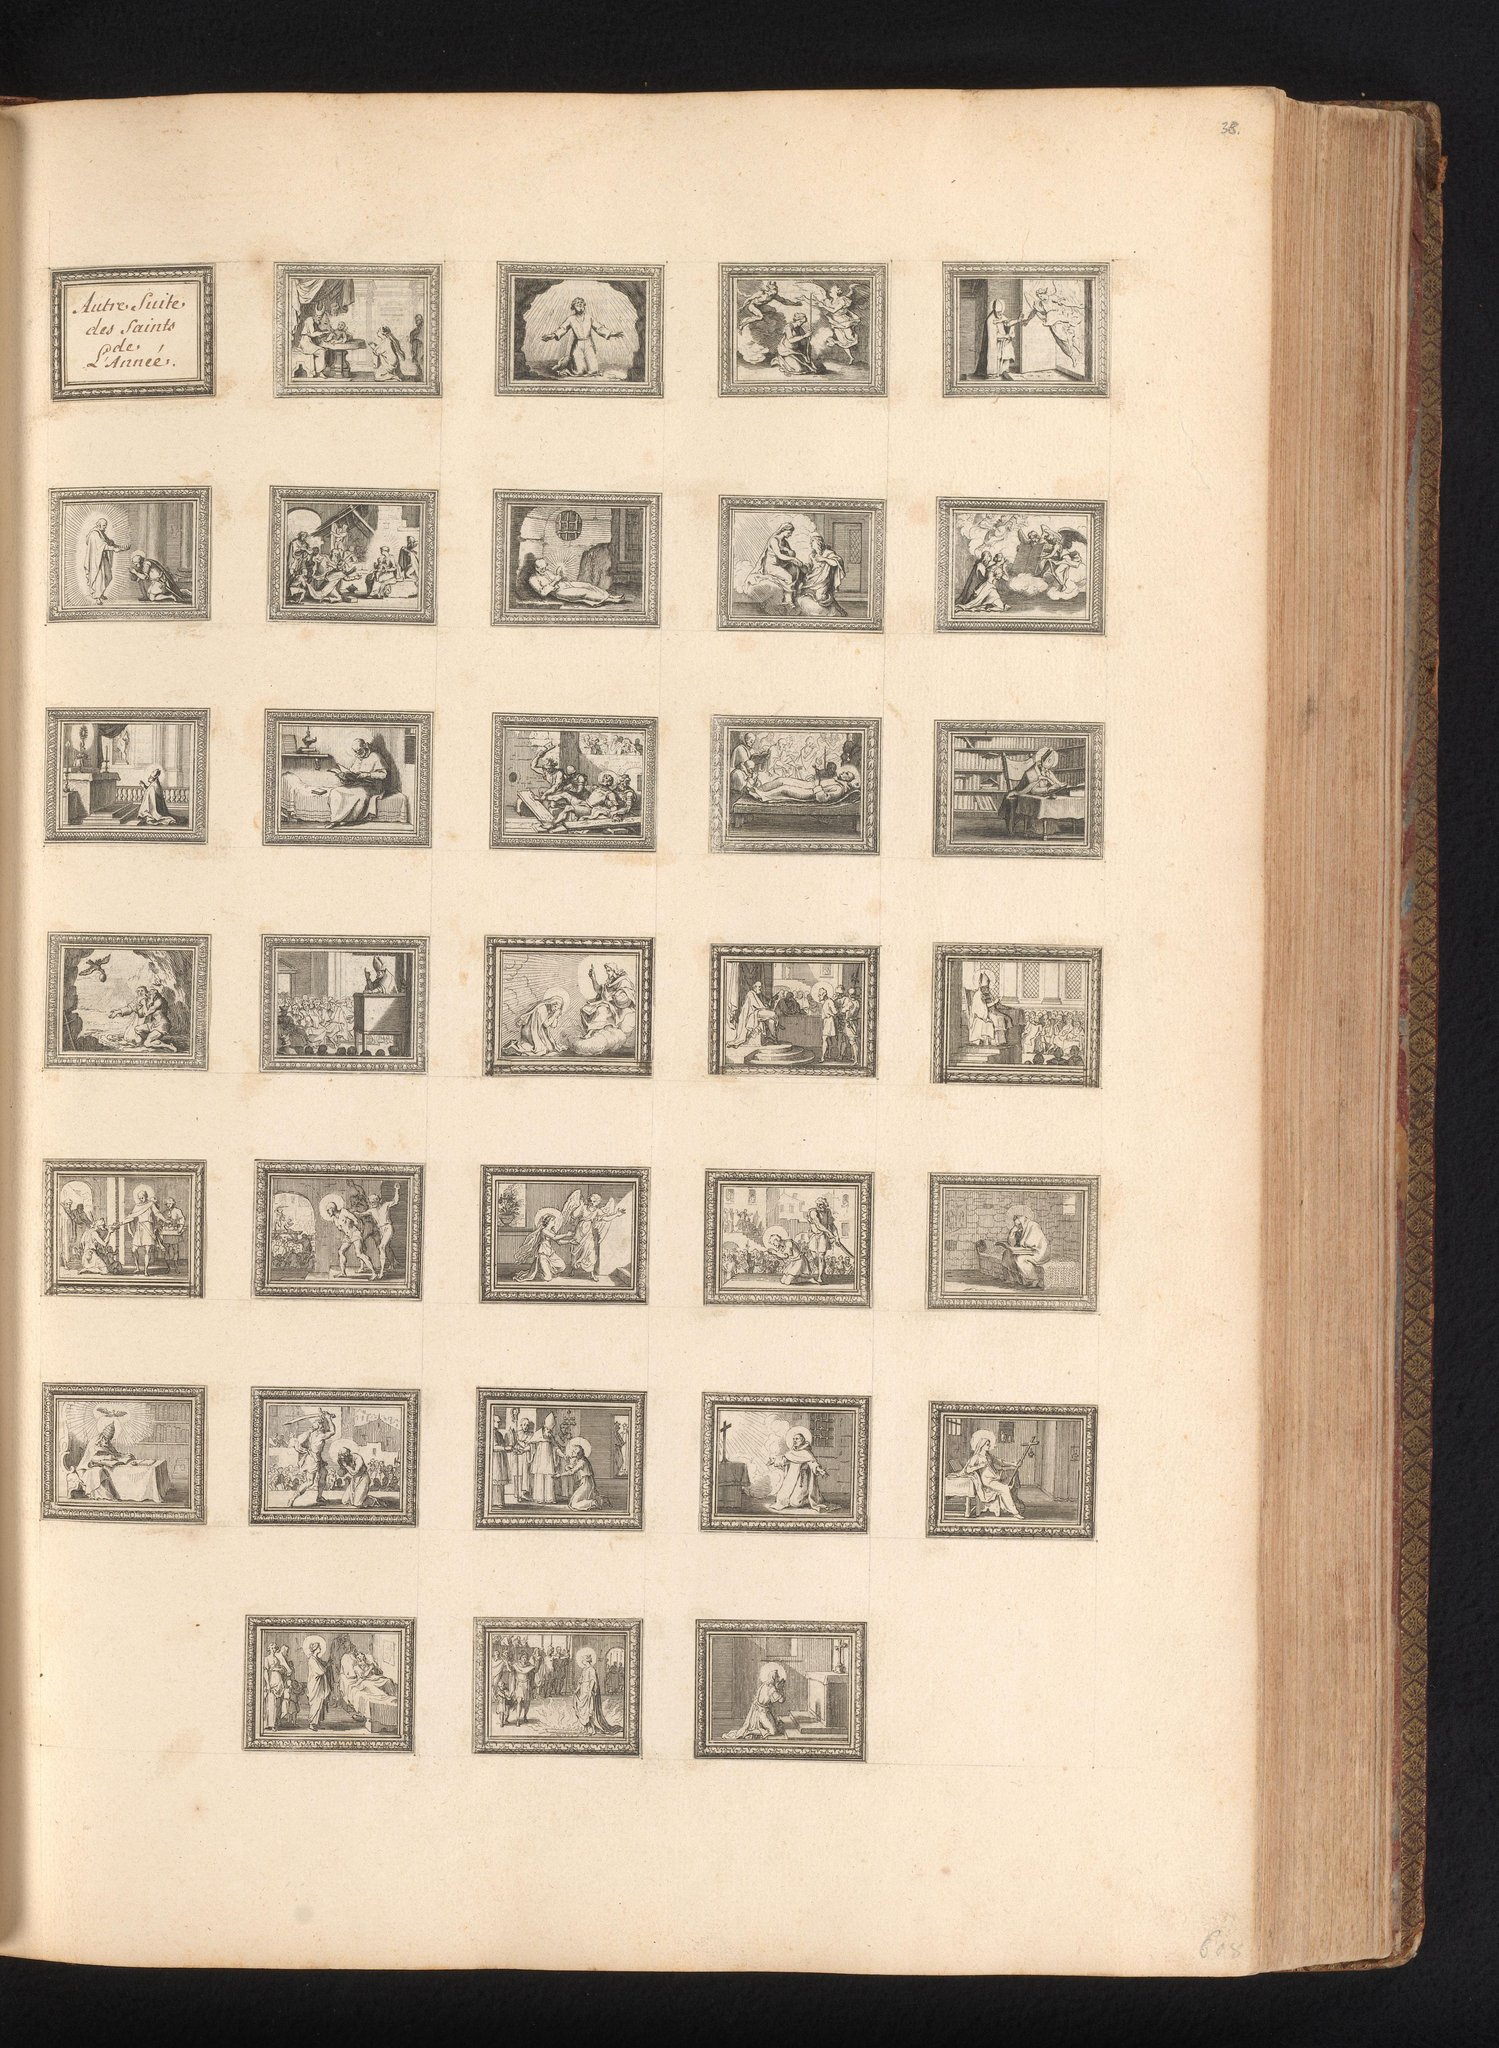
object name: album leaf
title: Heiligen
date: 1647-1706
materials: ink, paper, pencil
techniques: etching, pen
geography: paris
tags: saints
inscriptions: inscription: ‘Autre Suite des Saints de L'Anneé.’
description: Prenten maken deel uit van een serie met voorstellingen van heiligen behorende tot verschillende maanden van het jaar. De serie staat ook wel bekend als 'Les Saints de Gantrel'.